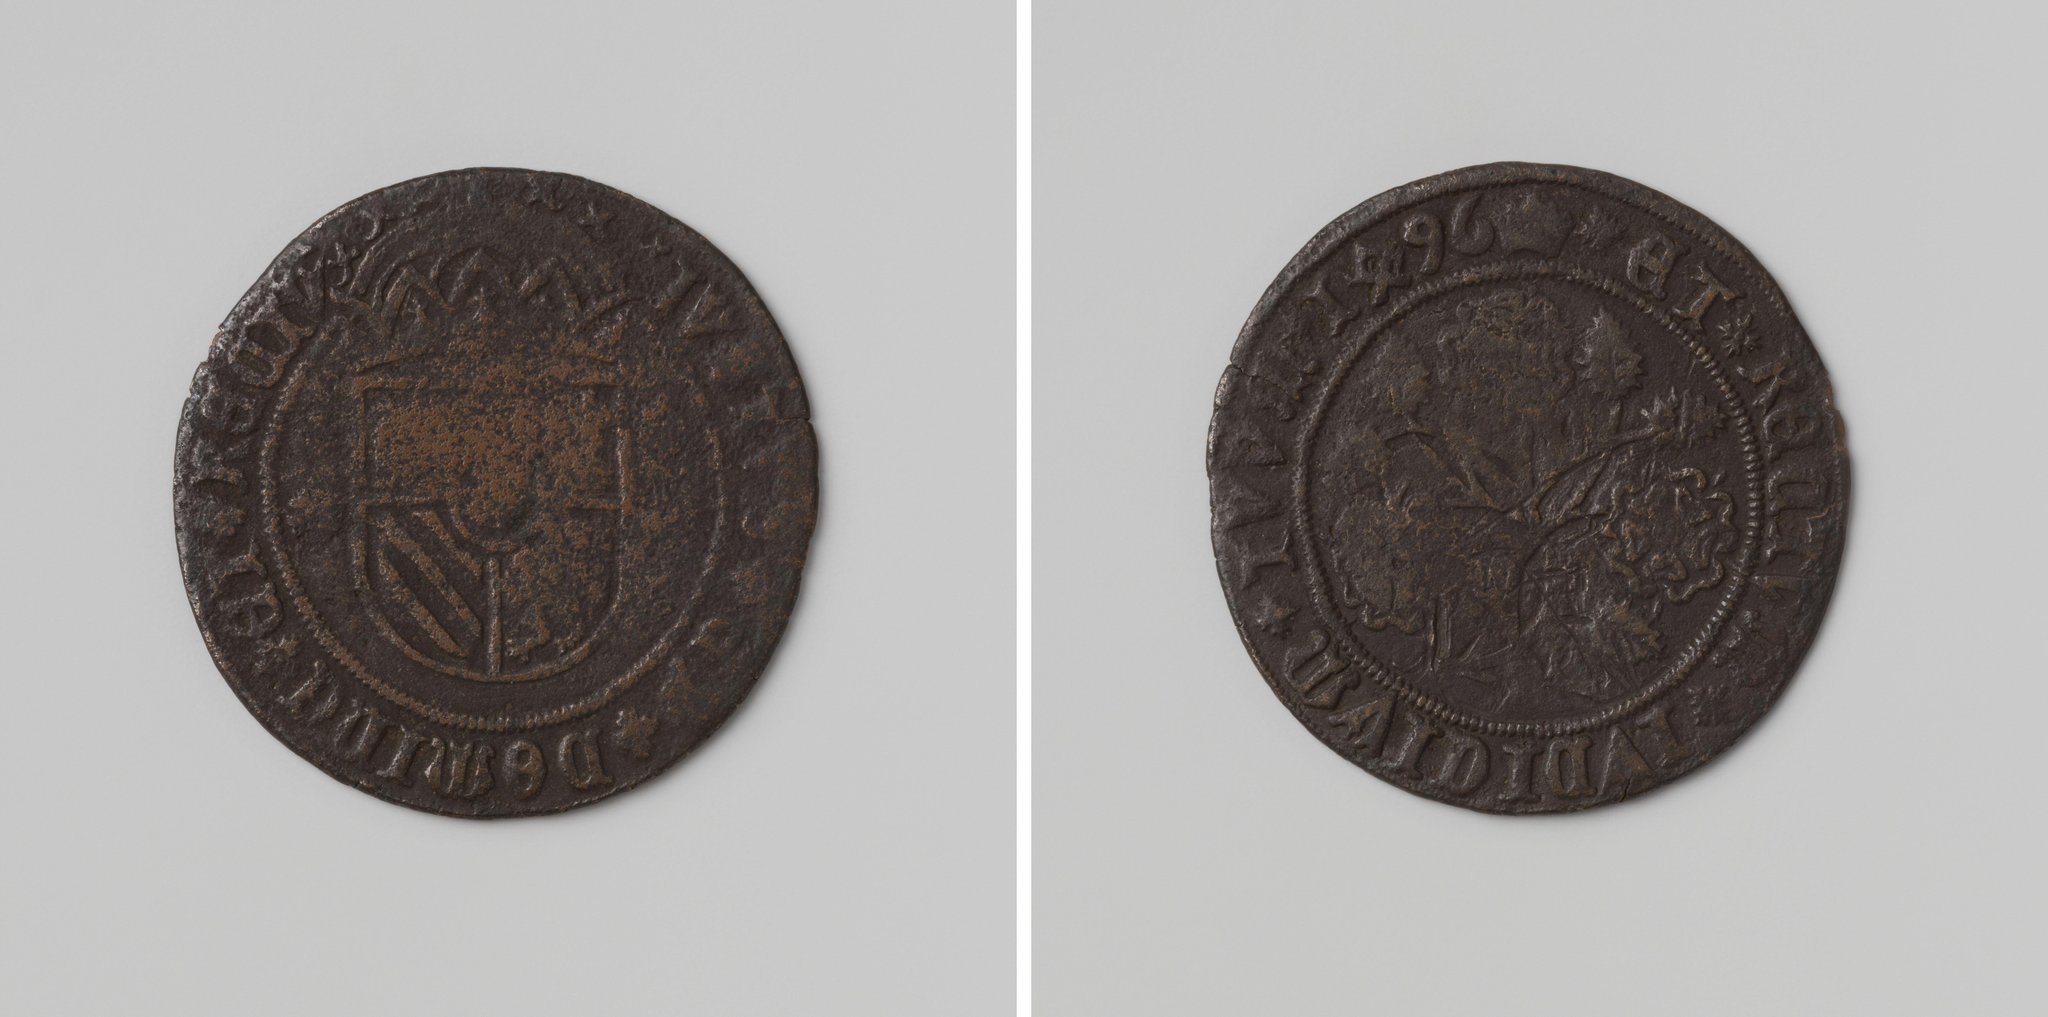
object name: jeton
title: Huwelijk van Filips de Schone, hertog van Bourgondie met Johanna, prinses van Castillie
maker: Anonymous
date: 1496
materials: copper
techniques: striking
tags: filips de schone (hertog van bourgondië)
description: Koperen penning. Voorzijde: gekroond wapenschild tussen twee rozetten binnen omschrift. Keerzijde: twee rozetakken en drie rozen binnen omschrift